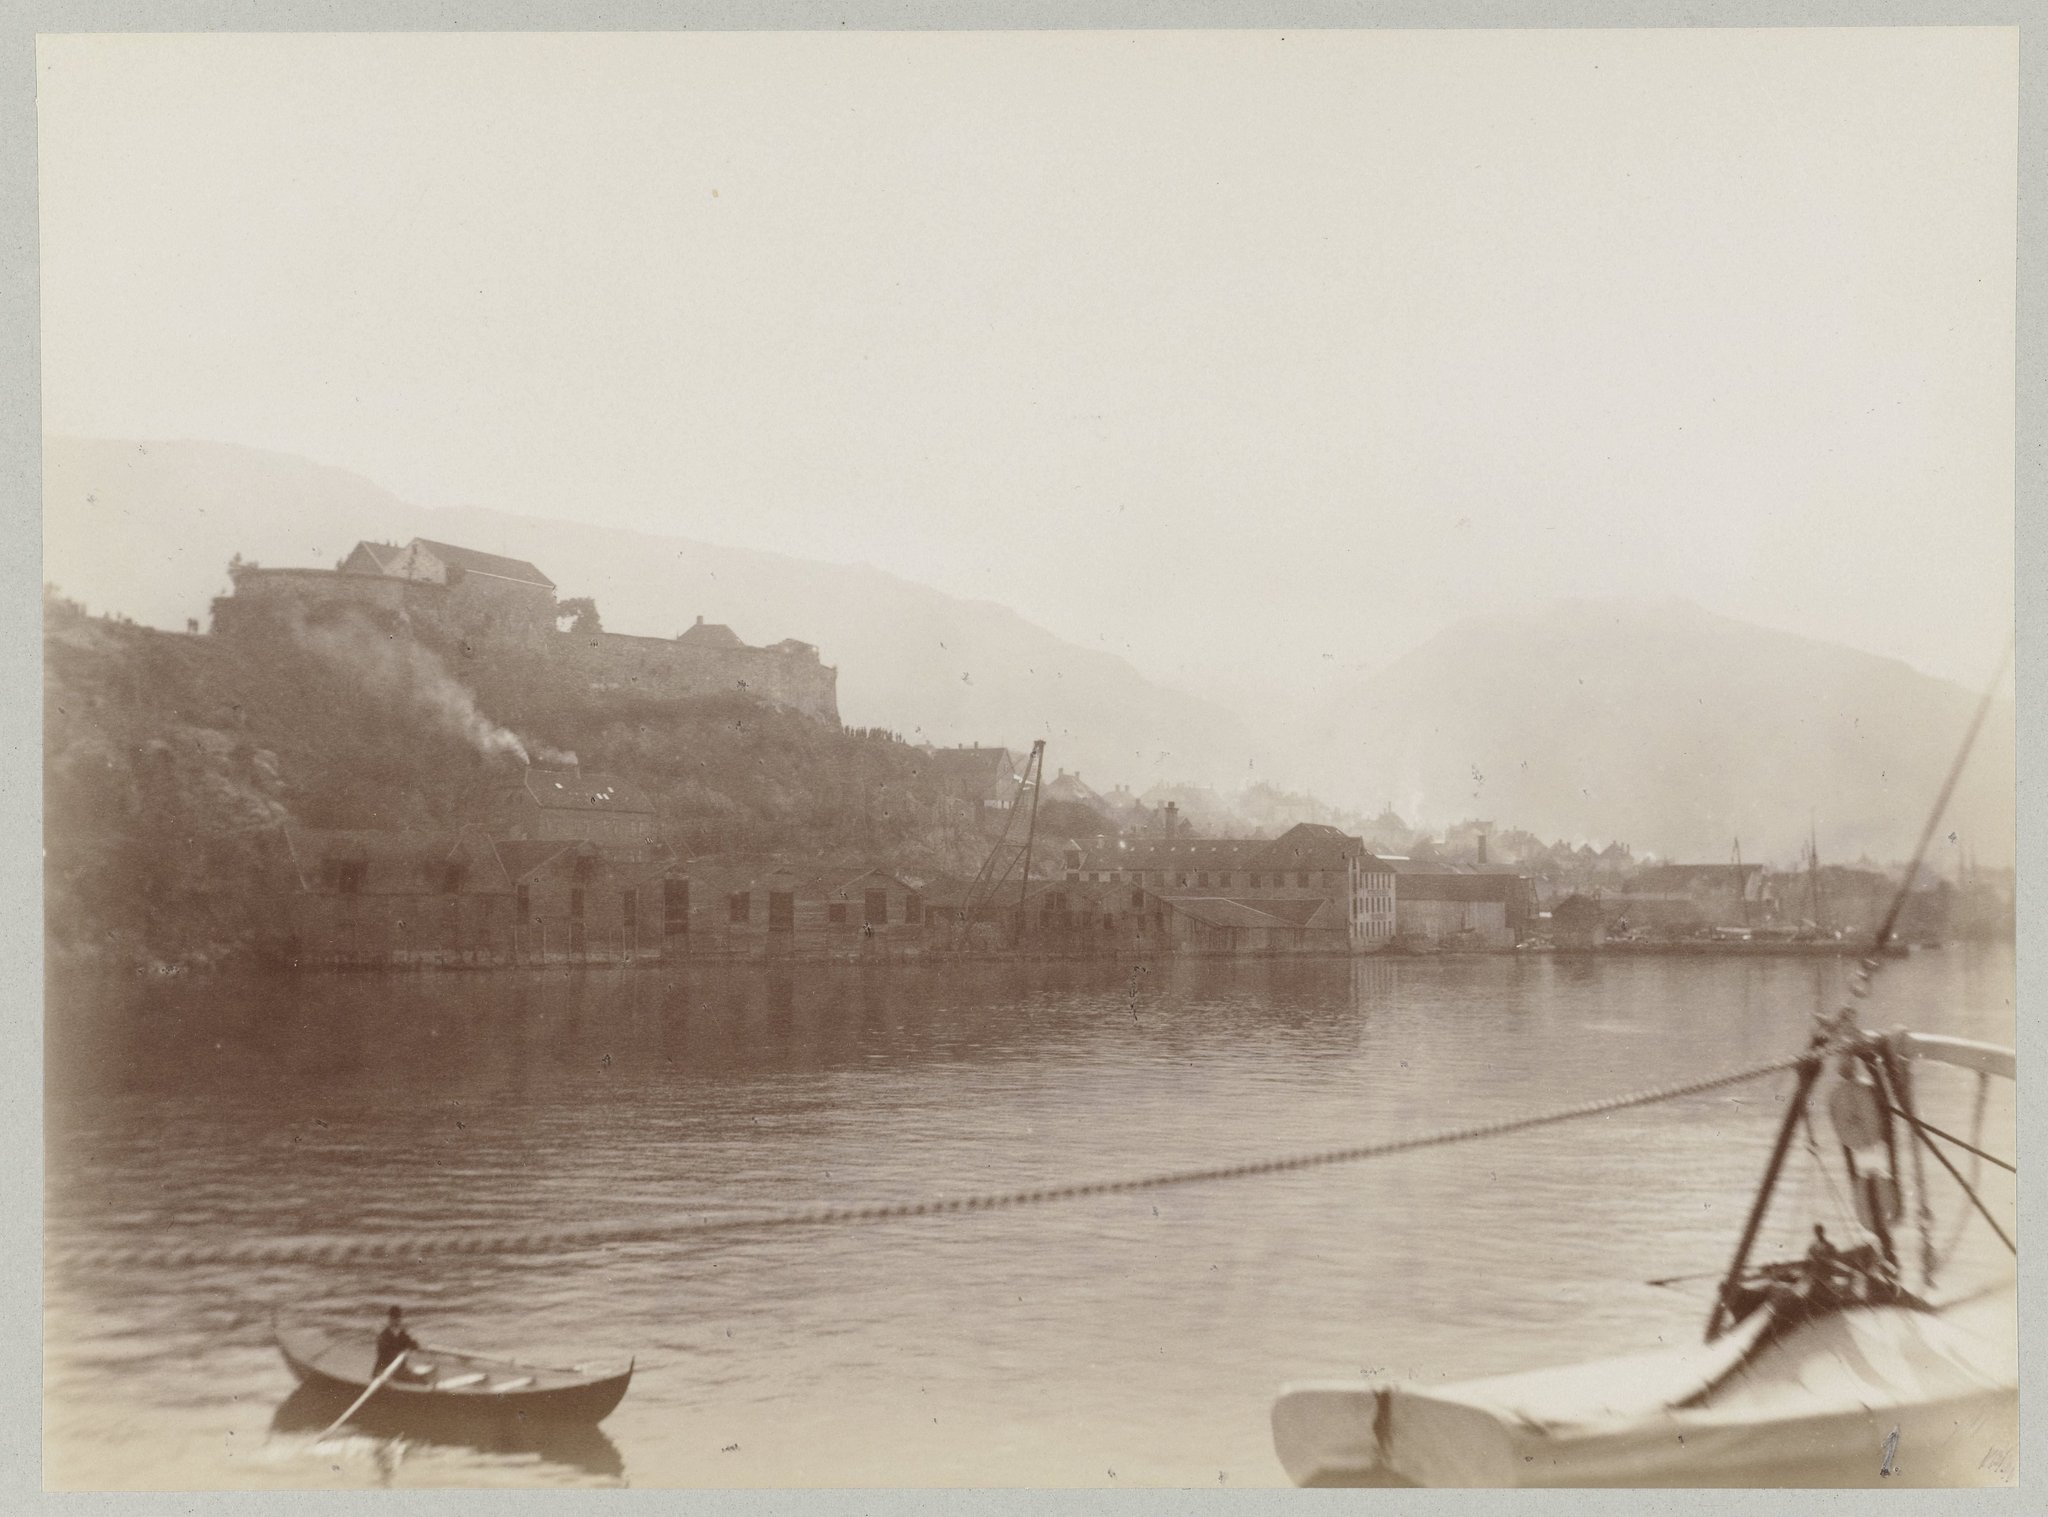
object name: photograph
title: Bergen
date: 1807-1889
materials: cardboard, paper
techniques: albumen print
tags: norway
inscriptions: number: ‘11’, number: ‘1’